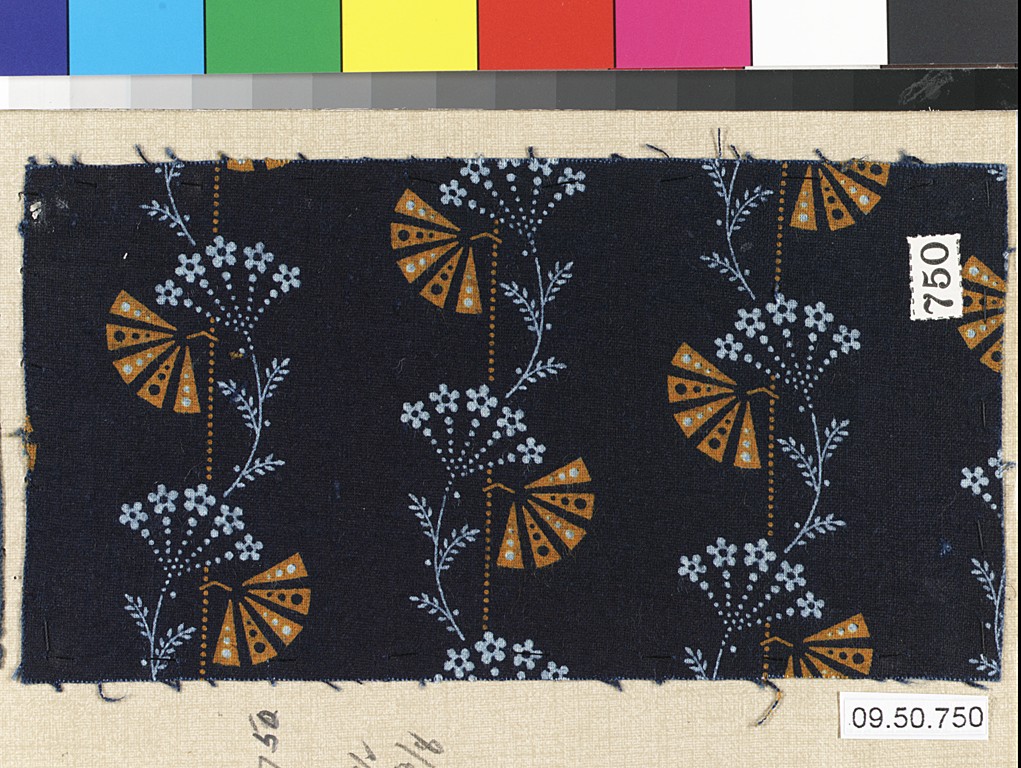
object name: piece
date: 1801-1900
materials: cotton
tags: flowers,leaves